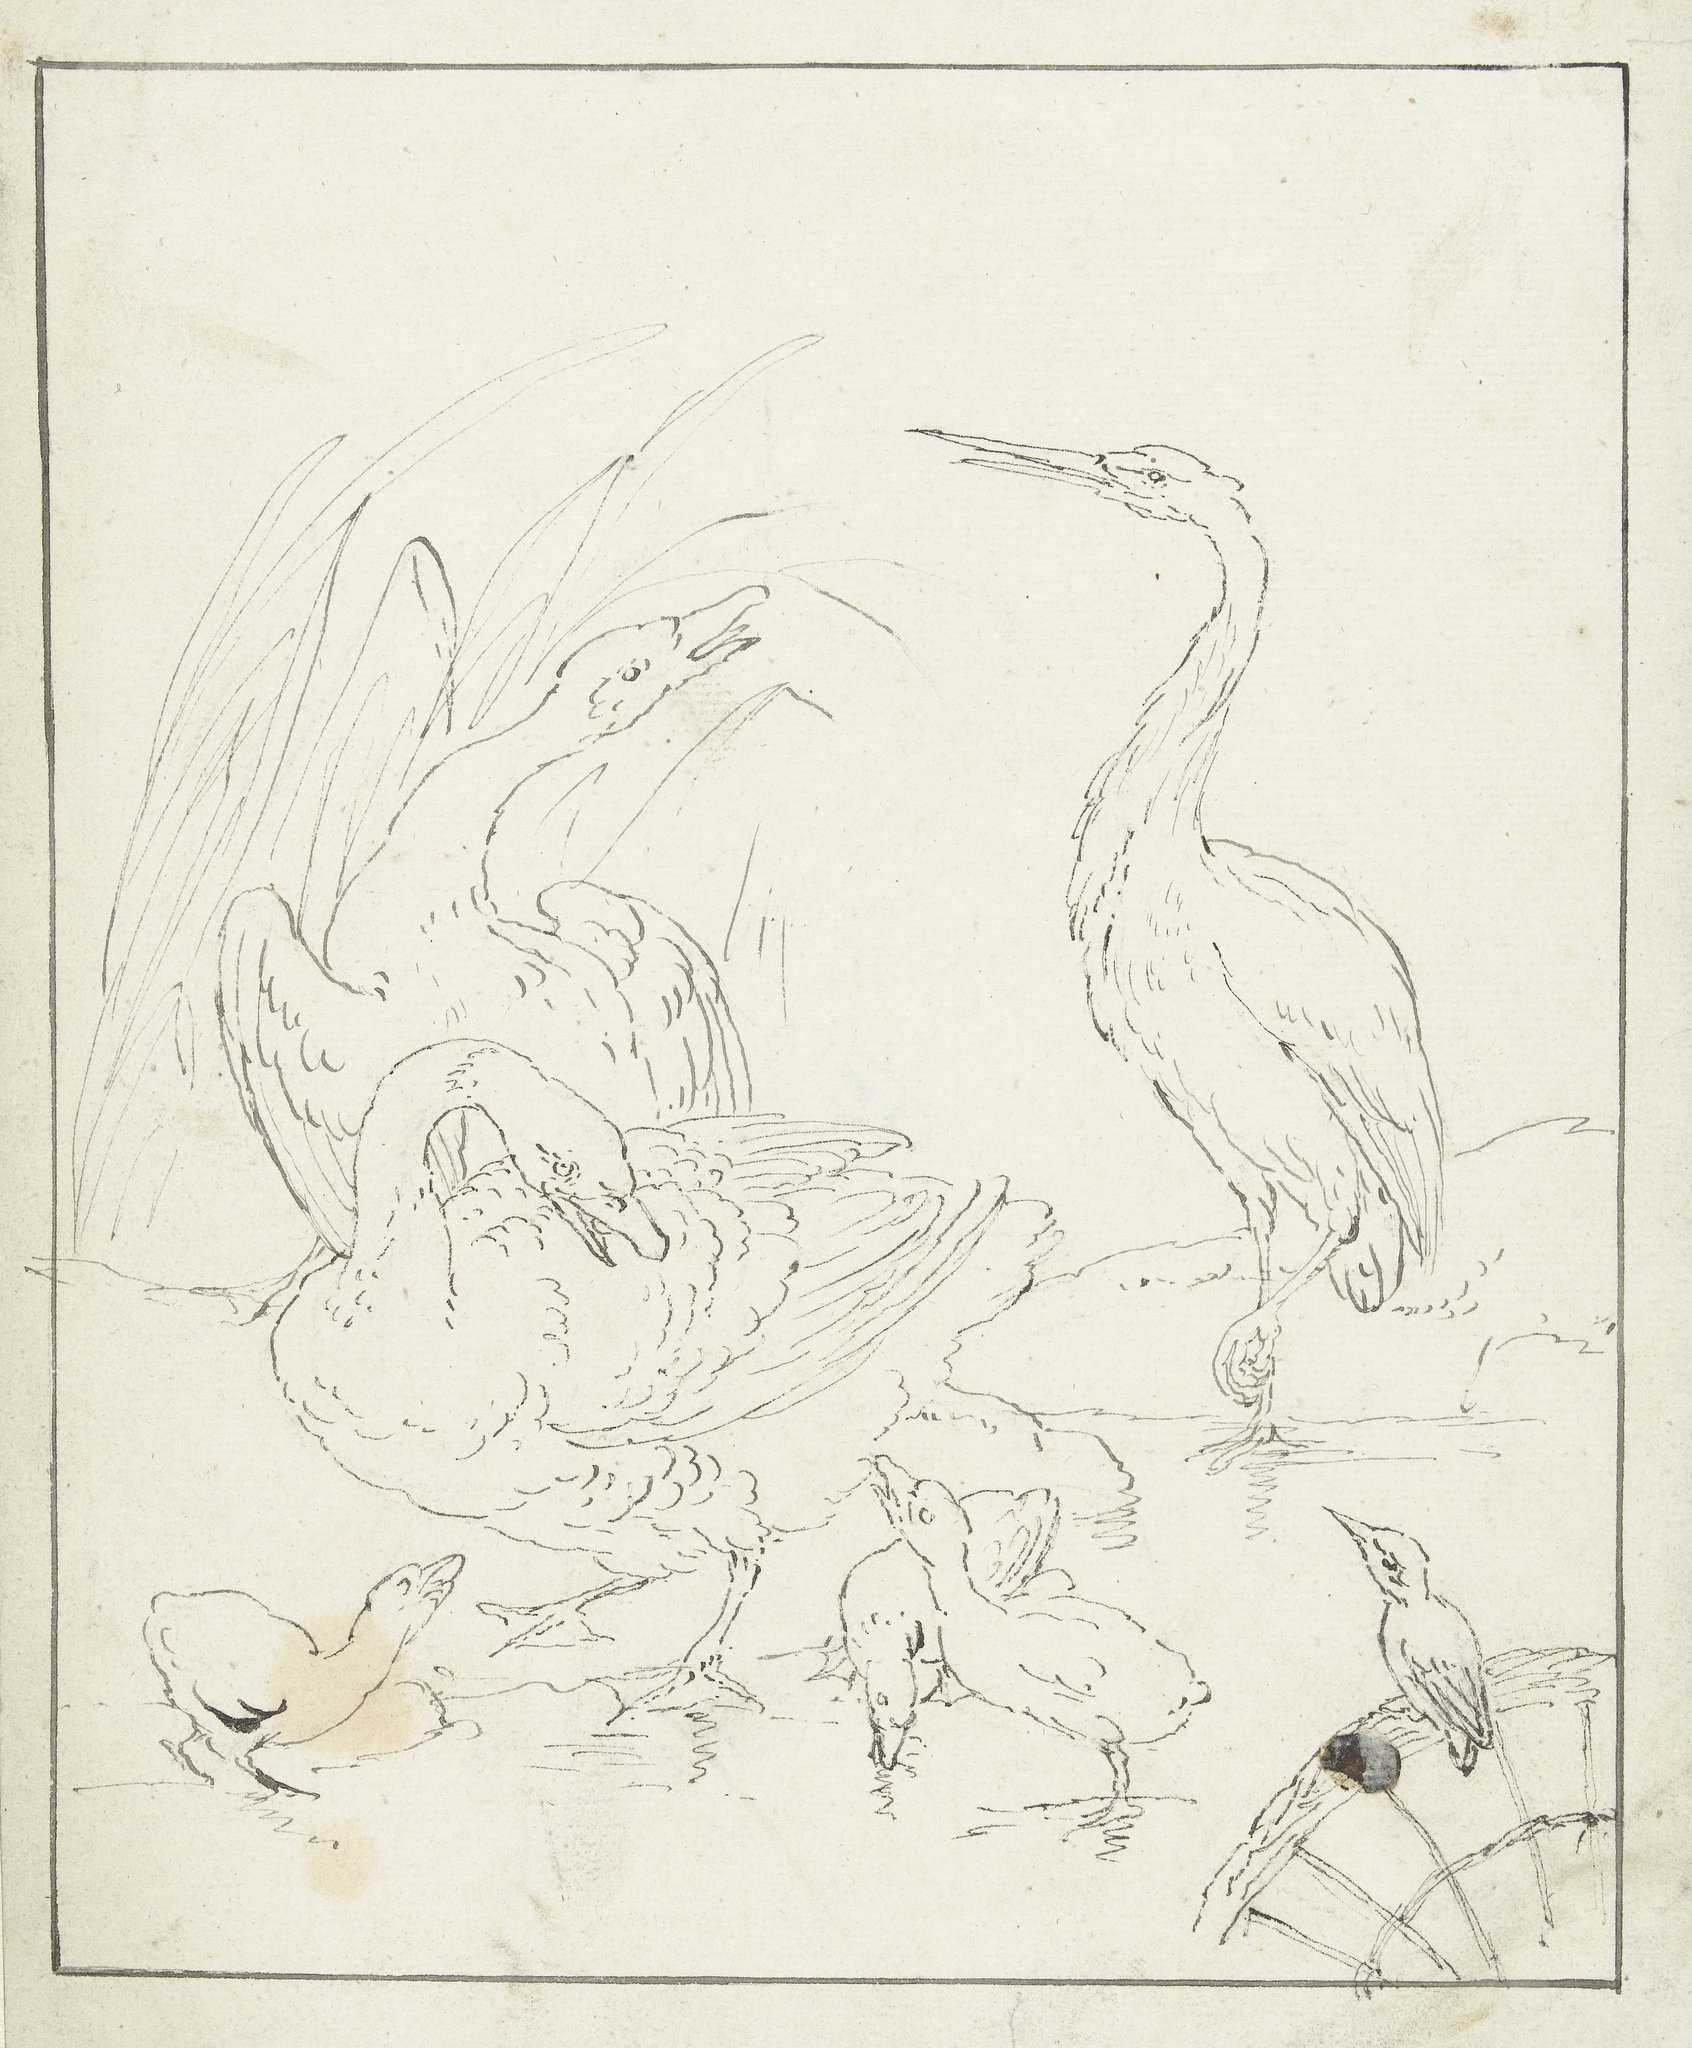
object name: drawing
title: Ontwerp voor een kamerversiering: een paneel met vogels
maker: abraham meertens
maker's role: draughtsman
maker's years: 1757-1823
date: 1767-1823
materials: ink, paper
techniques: pen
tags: groups of birds